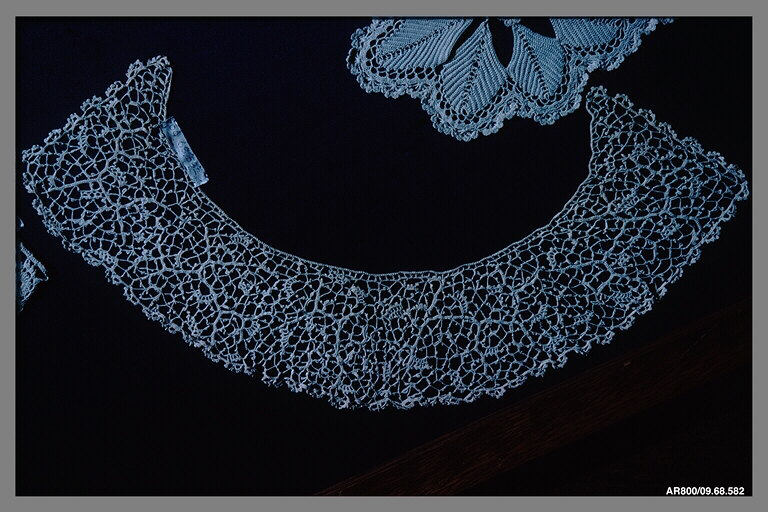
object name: collar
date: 1801-1900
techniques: crochet